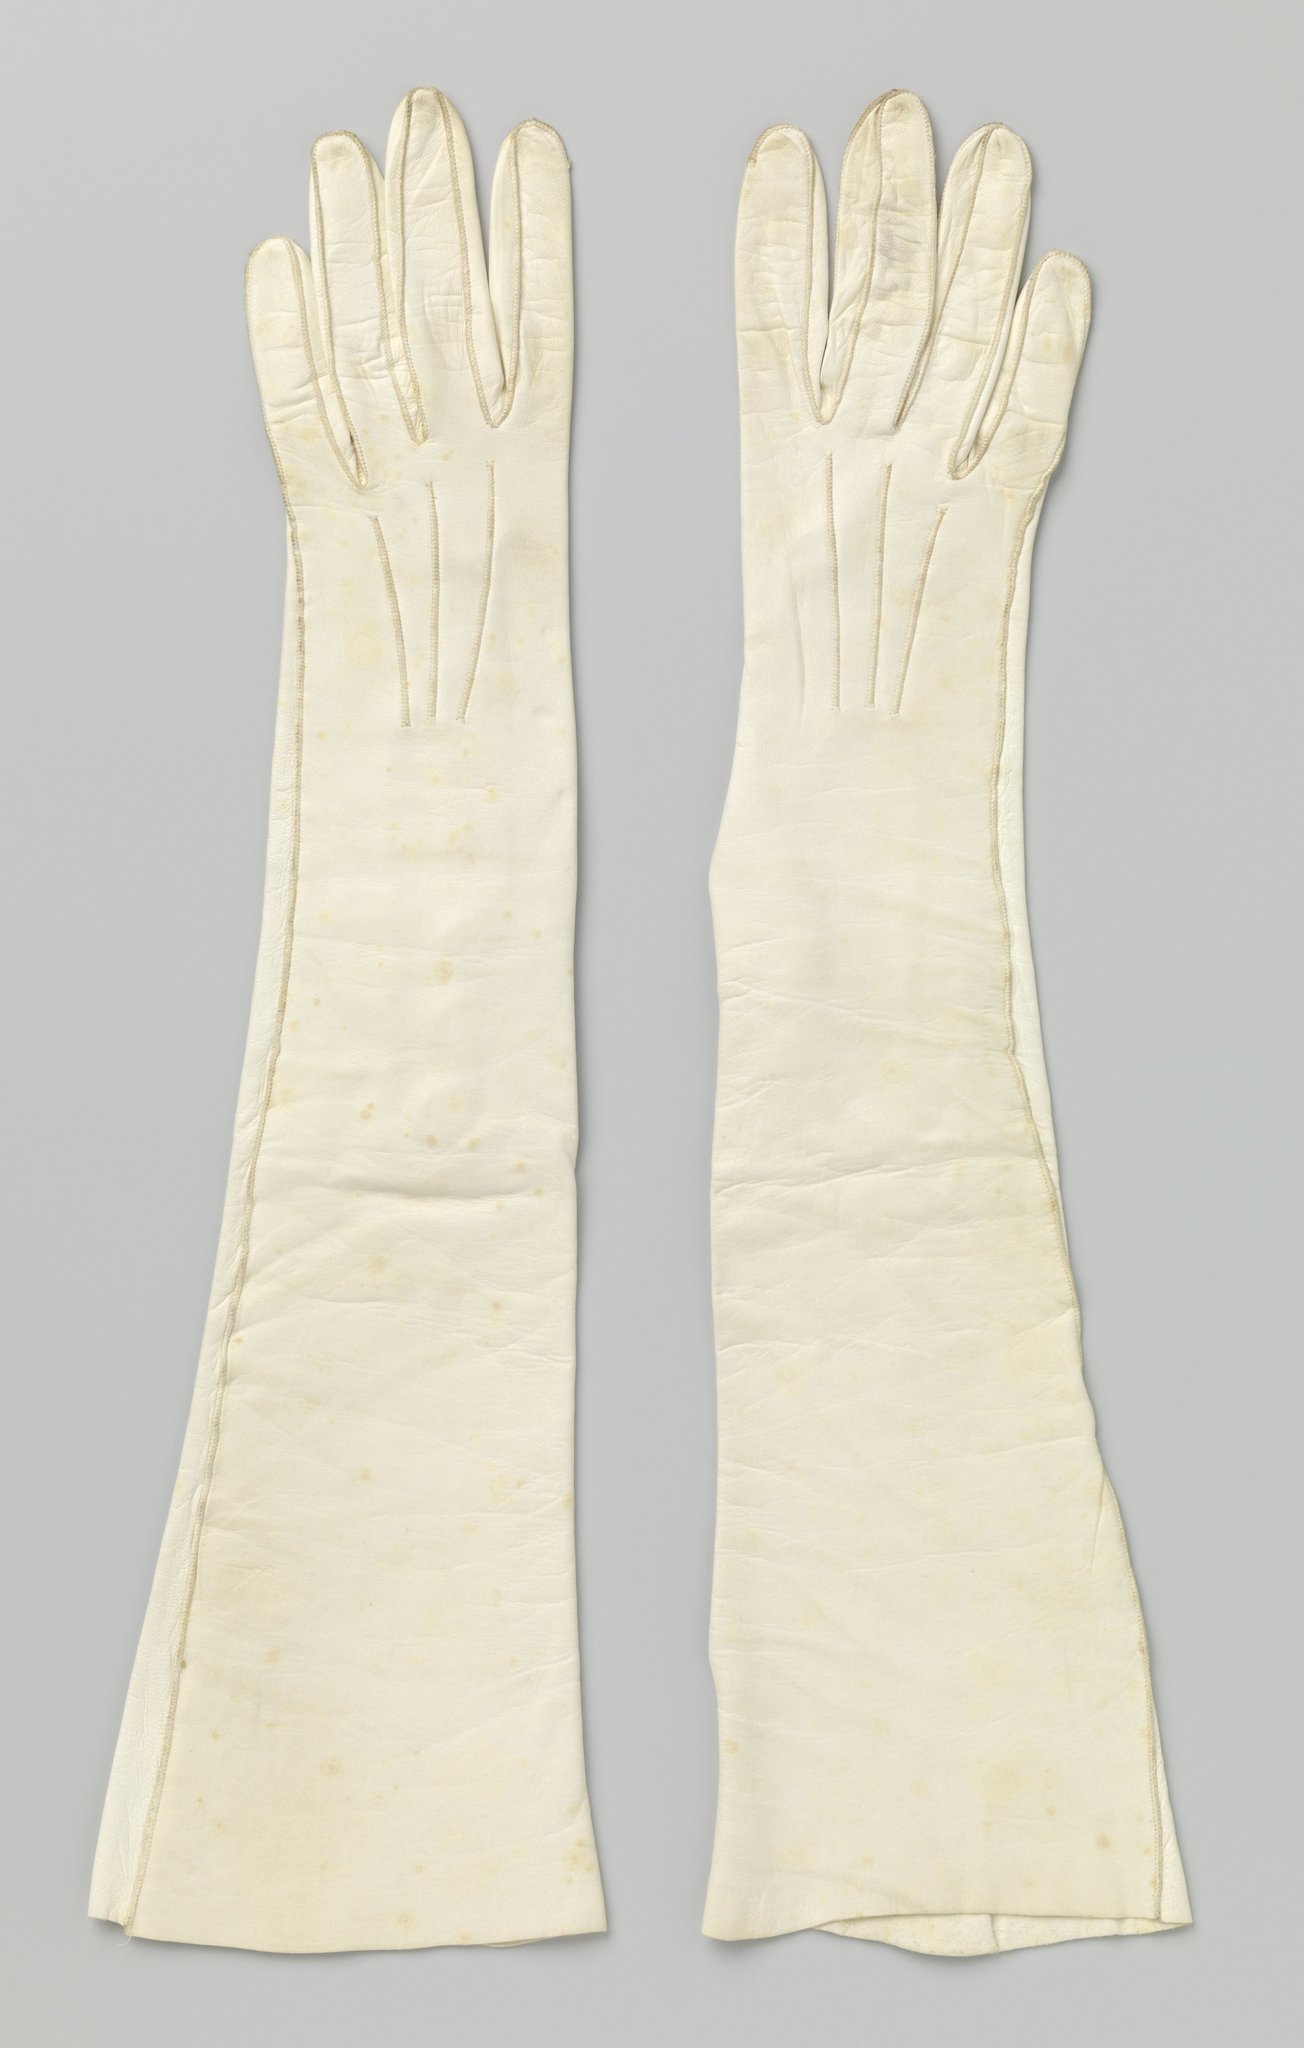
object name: clothing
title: Handschoen van wit leer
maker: Anonymous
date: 1900-1925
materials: leather, plastic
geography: netherlands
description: Linkeravondhandschoen, halflang, van wit leer. Bij de pols een split met drie parelmoerkleurige knopen.